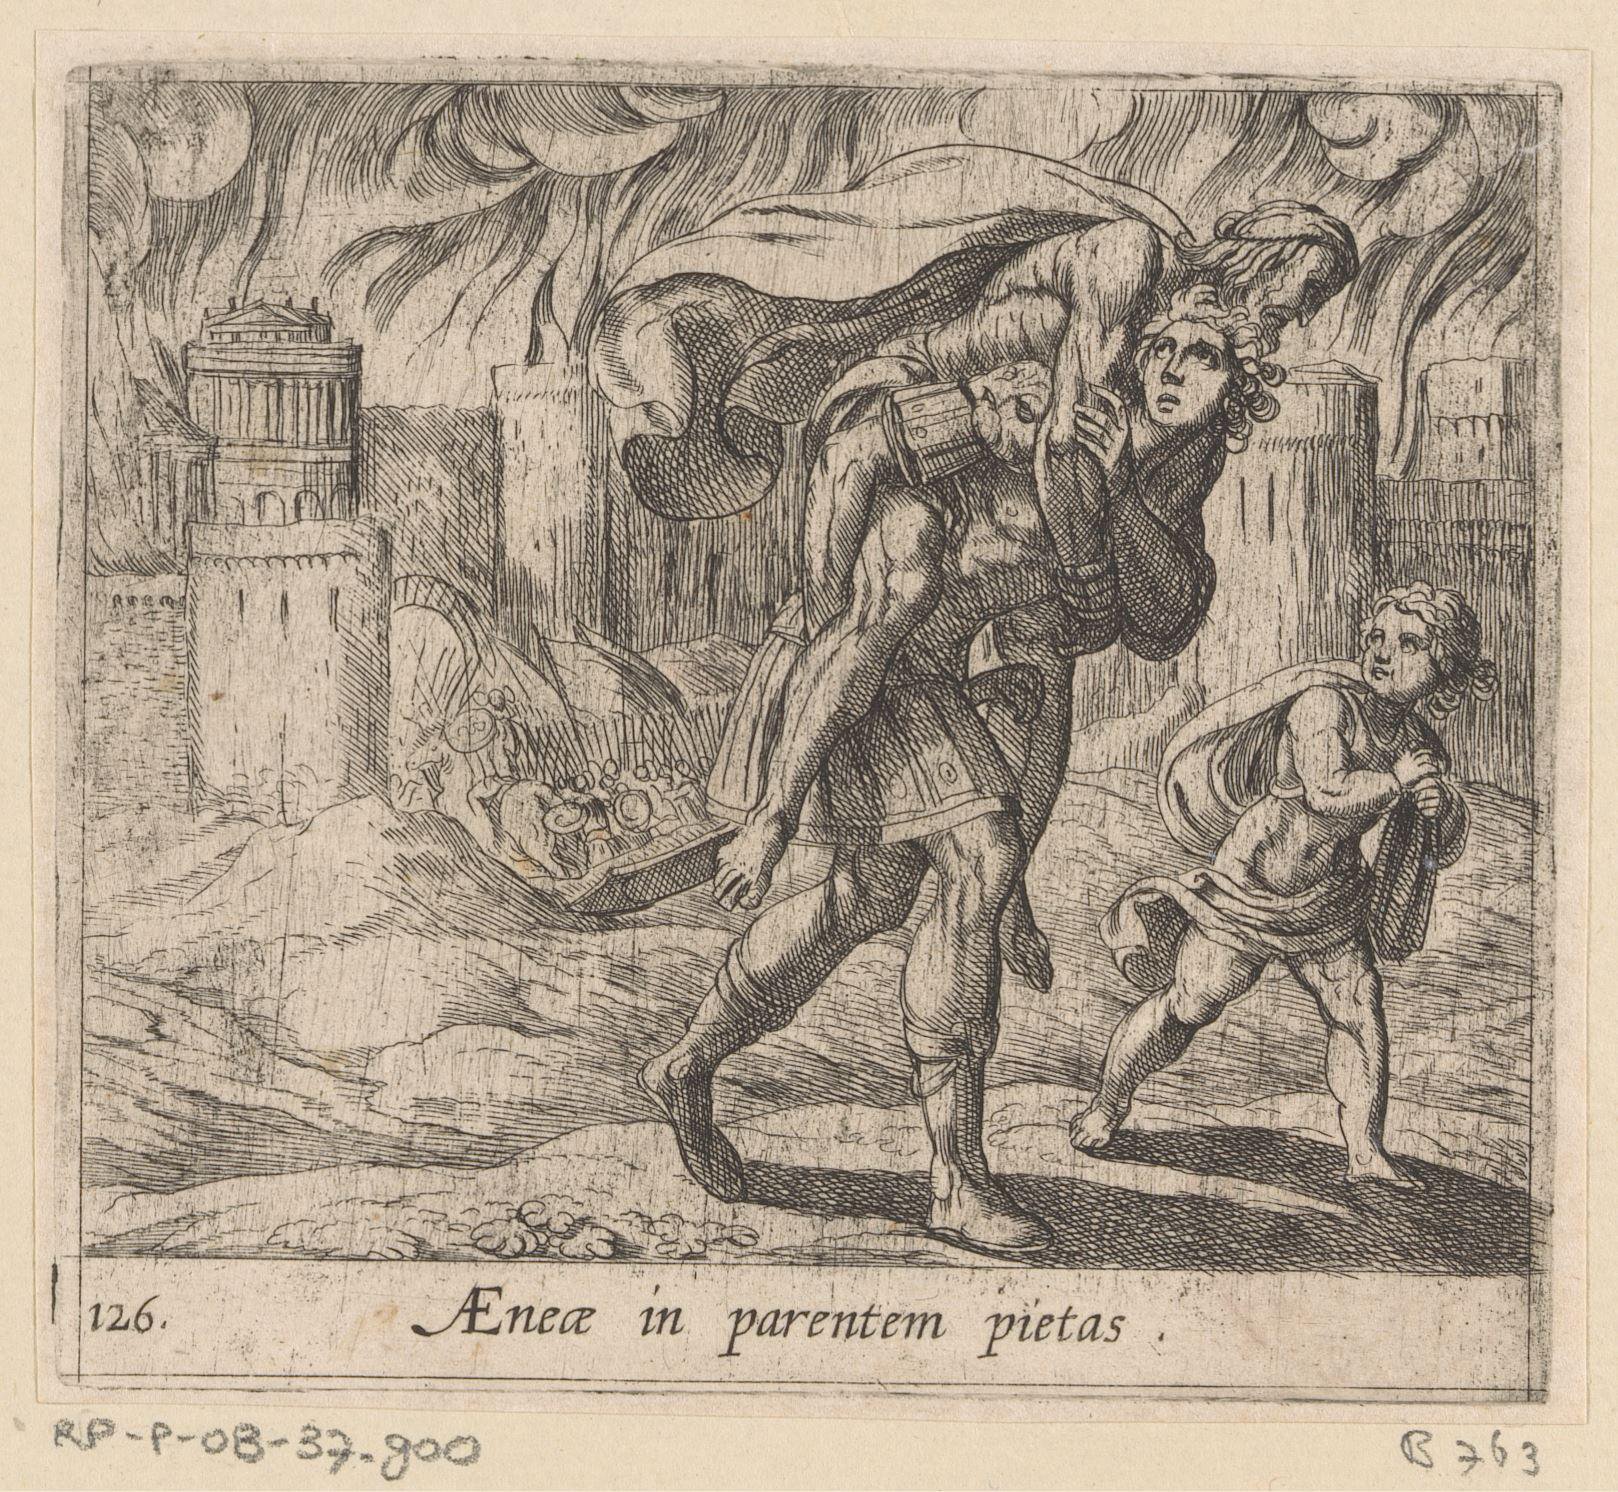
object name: print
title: Metamorfosen van Ovidius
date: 1606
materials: paper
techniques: etching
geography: italy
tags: 'pius aeneas': aeneas, leading ascanius, escapes from burning troy, carrying his father anchises with the penates; his wife creusa, who sets out with them, is lost on the way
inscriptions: collector's mark: Lugt 240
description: Aeneas draagt zijn vader Anchises op zijn rug. Rechts loopt Ascanius. Op de achtergrond het brandende Troje. Titel in het Latijn in ondermarge.